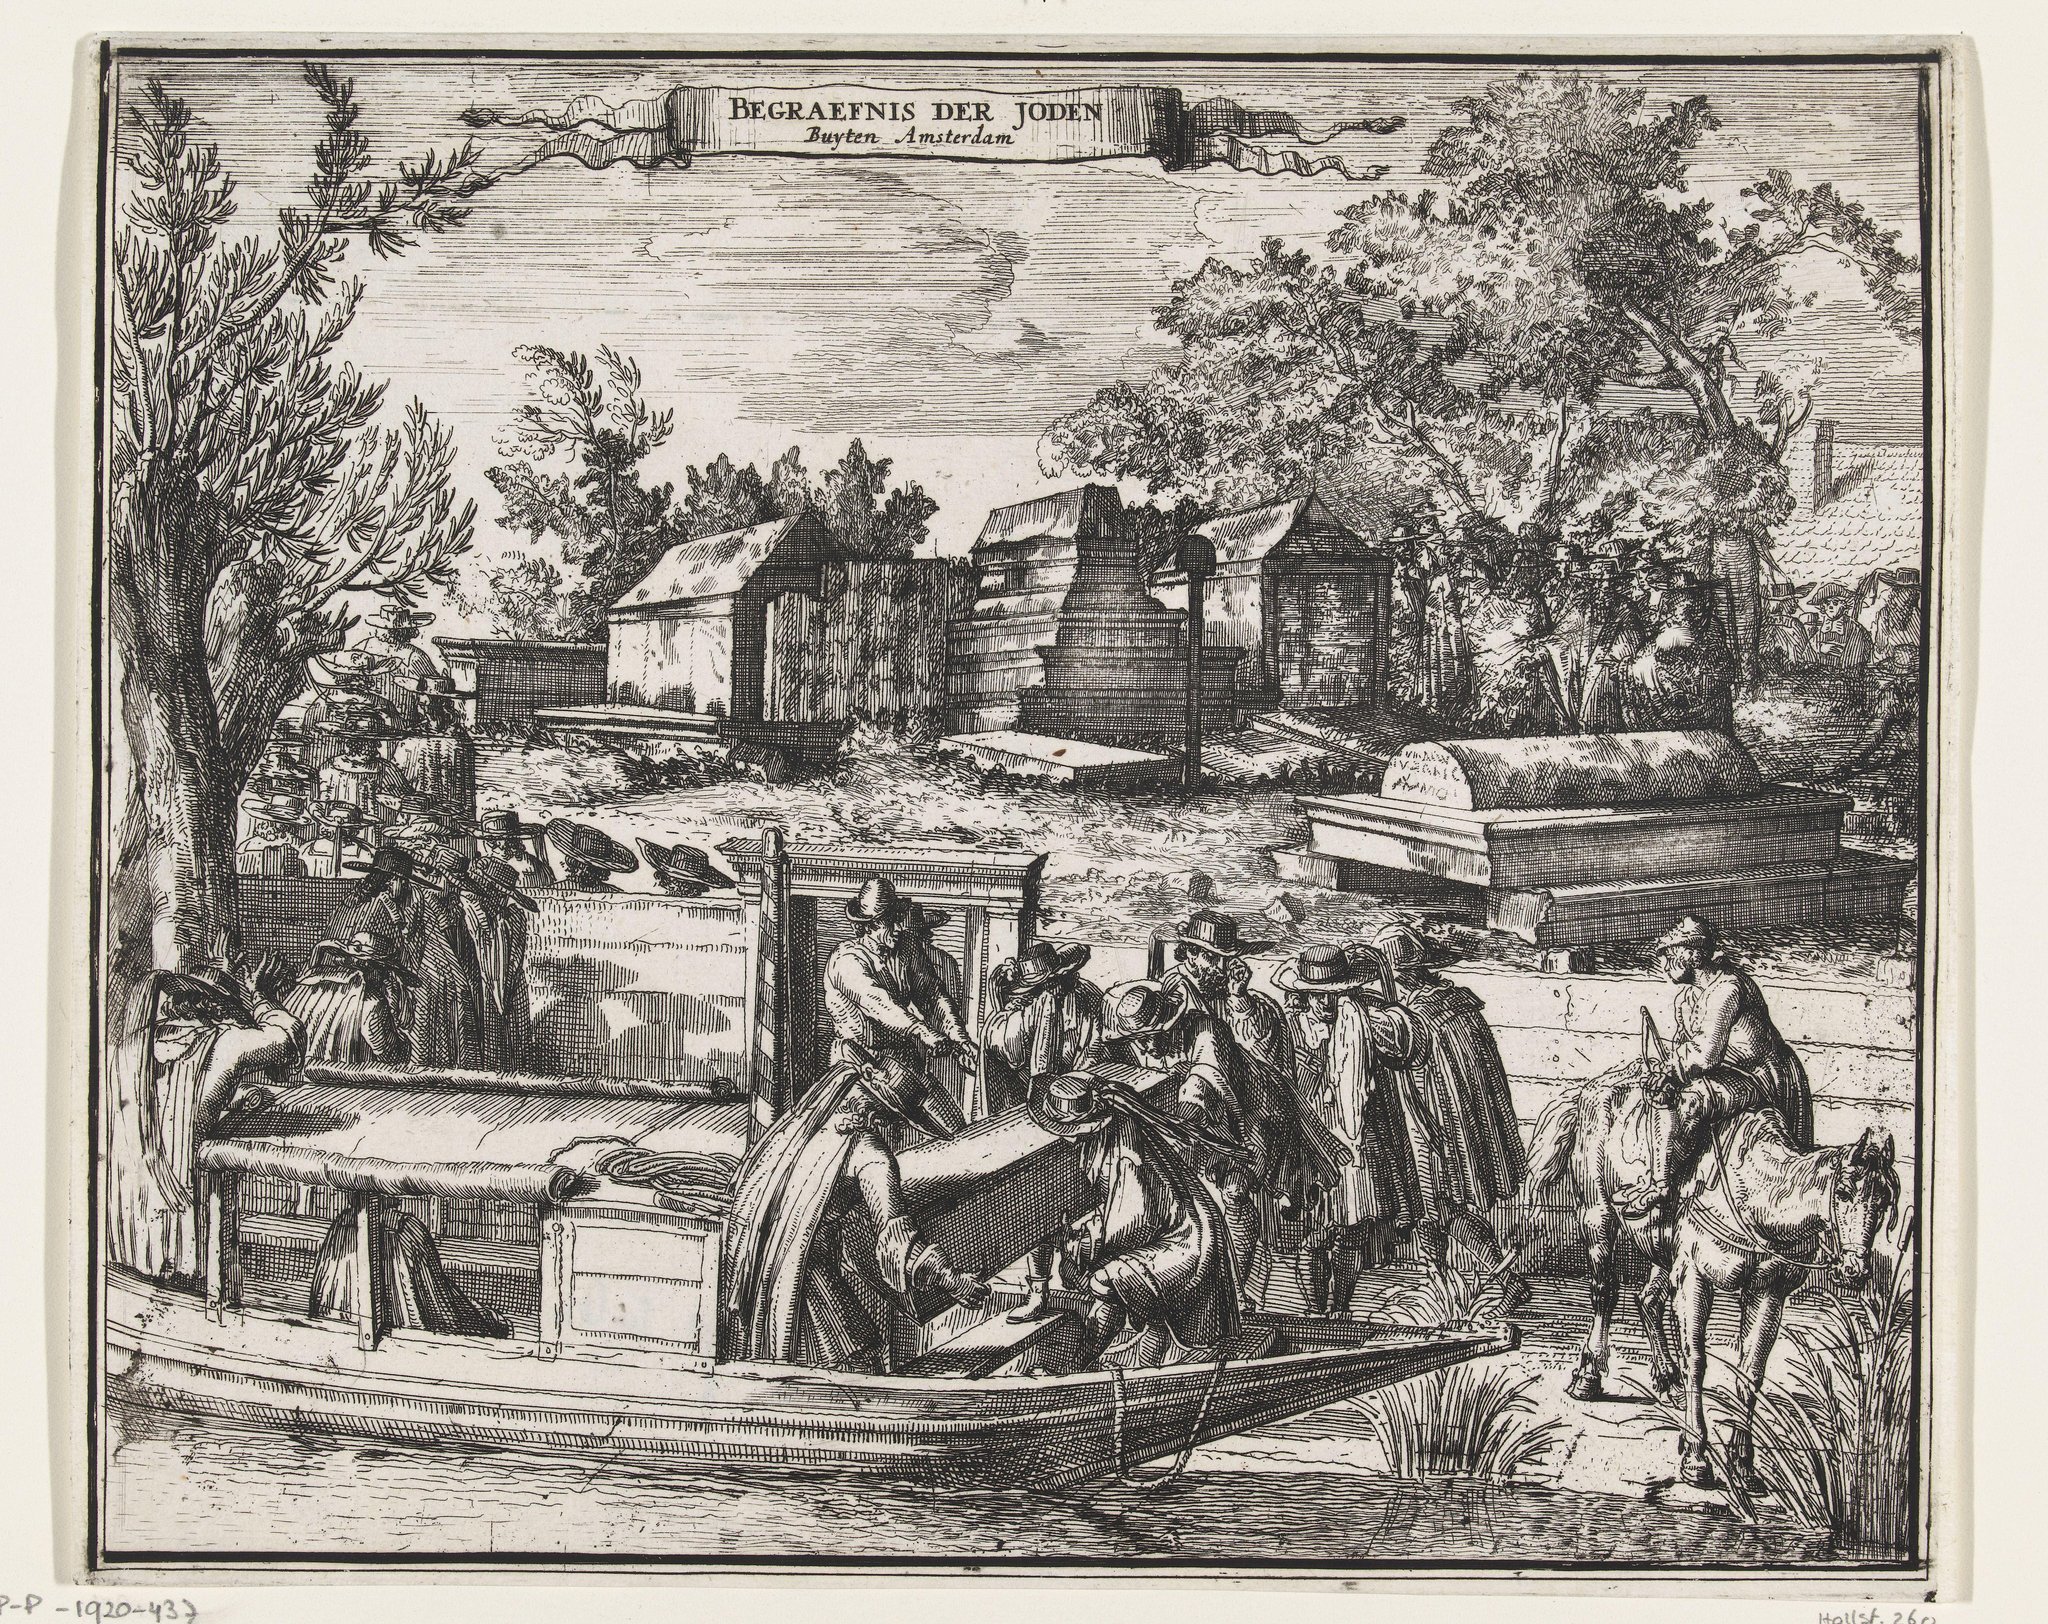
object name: print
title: Begraefnis der joden buyten Amsterdam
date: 1675-1695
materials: paper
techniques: engraving, etching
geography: northern netherlands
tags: 'sephardim' ~ jewish communities, churchyard, cemetery, death and burial ~ jewish customs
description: Gezicht op de Portugees-Joodse begraafplaats Beth Haim te Ouderkerk aan de Amstel. Op de voorgrond is een trekschuit met een grafkist en begrafenisgangers aangekomen. Van de drie centrale tombes is de middelste van Isaac Uziel en de linker van Elia Montalto. Op en voor de begraafplaats rouwende mannen. Boven in het midden een banderol met de titel.